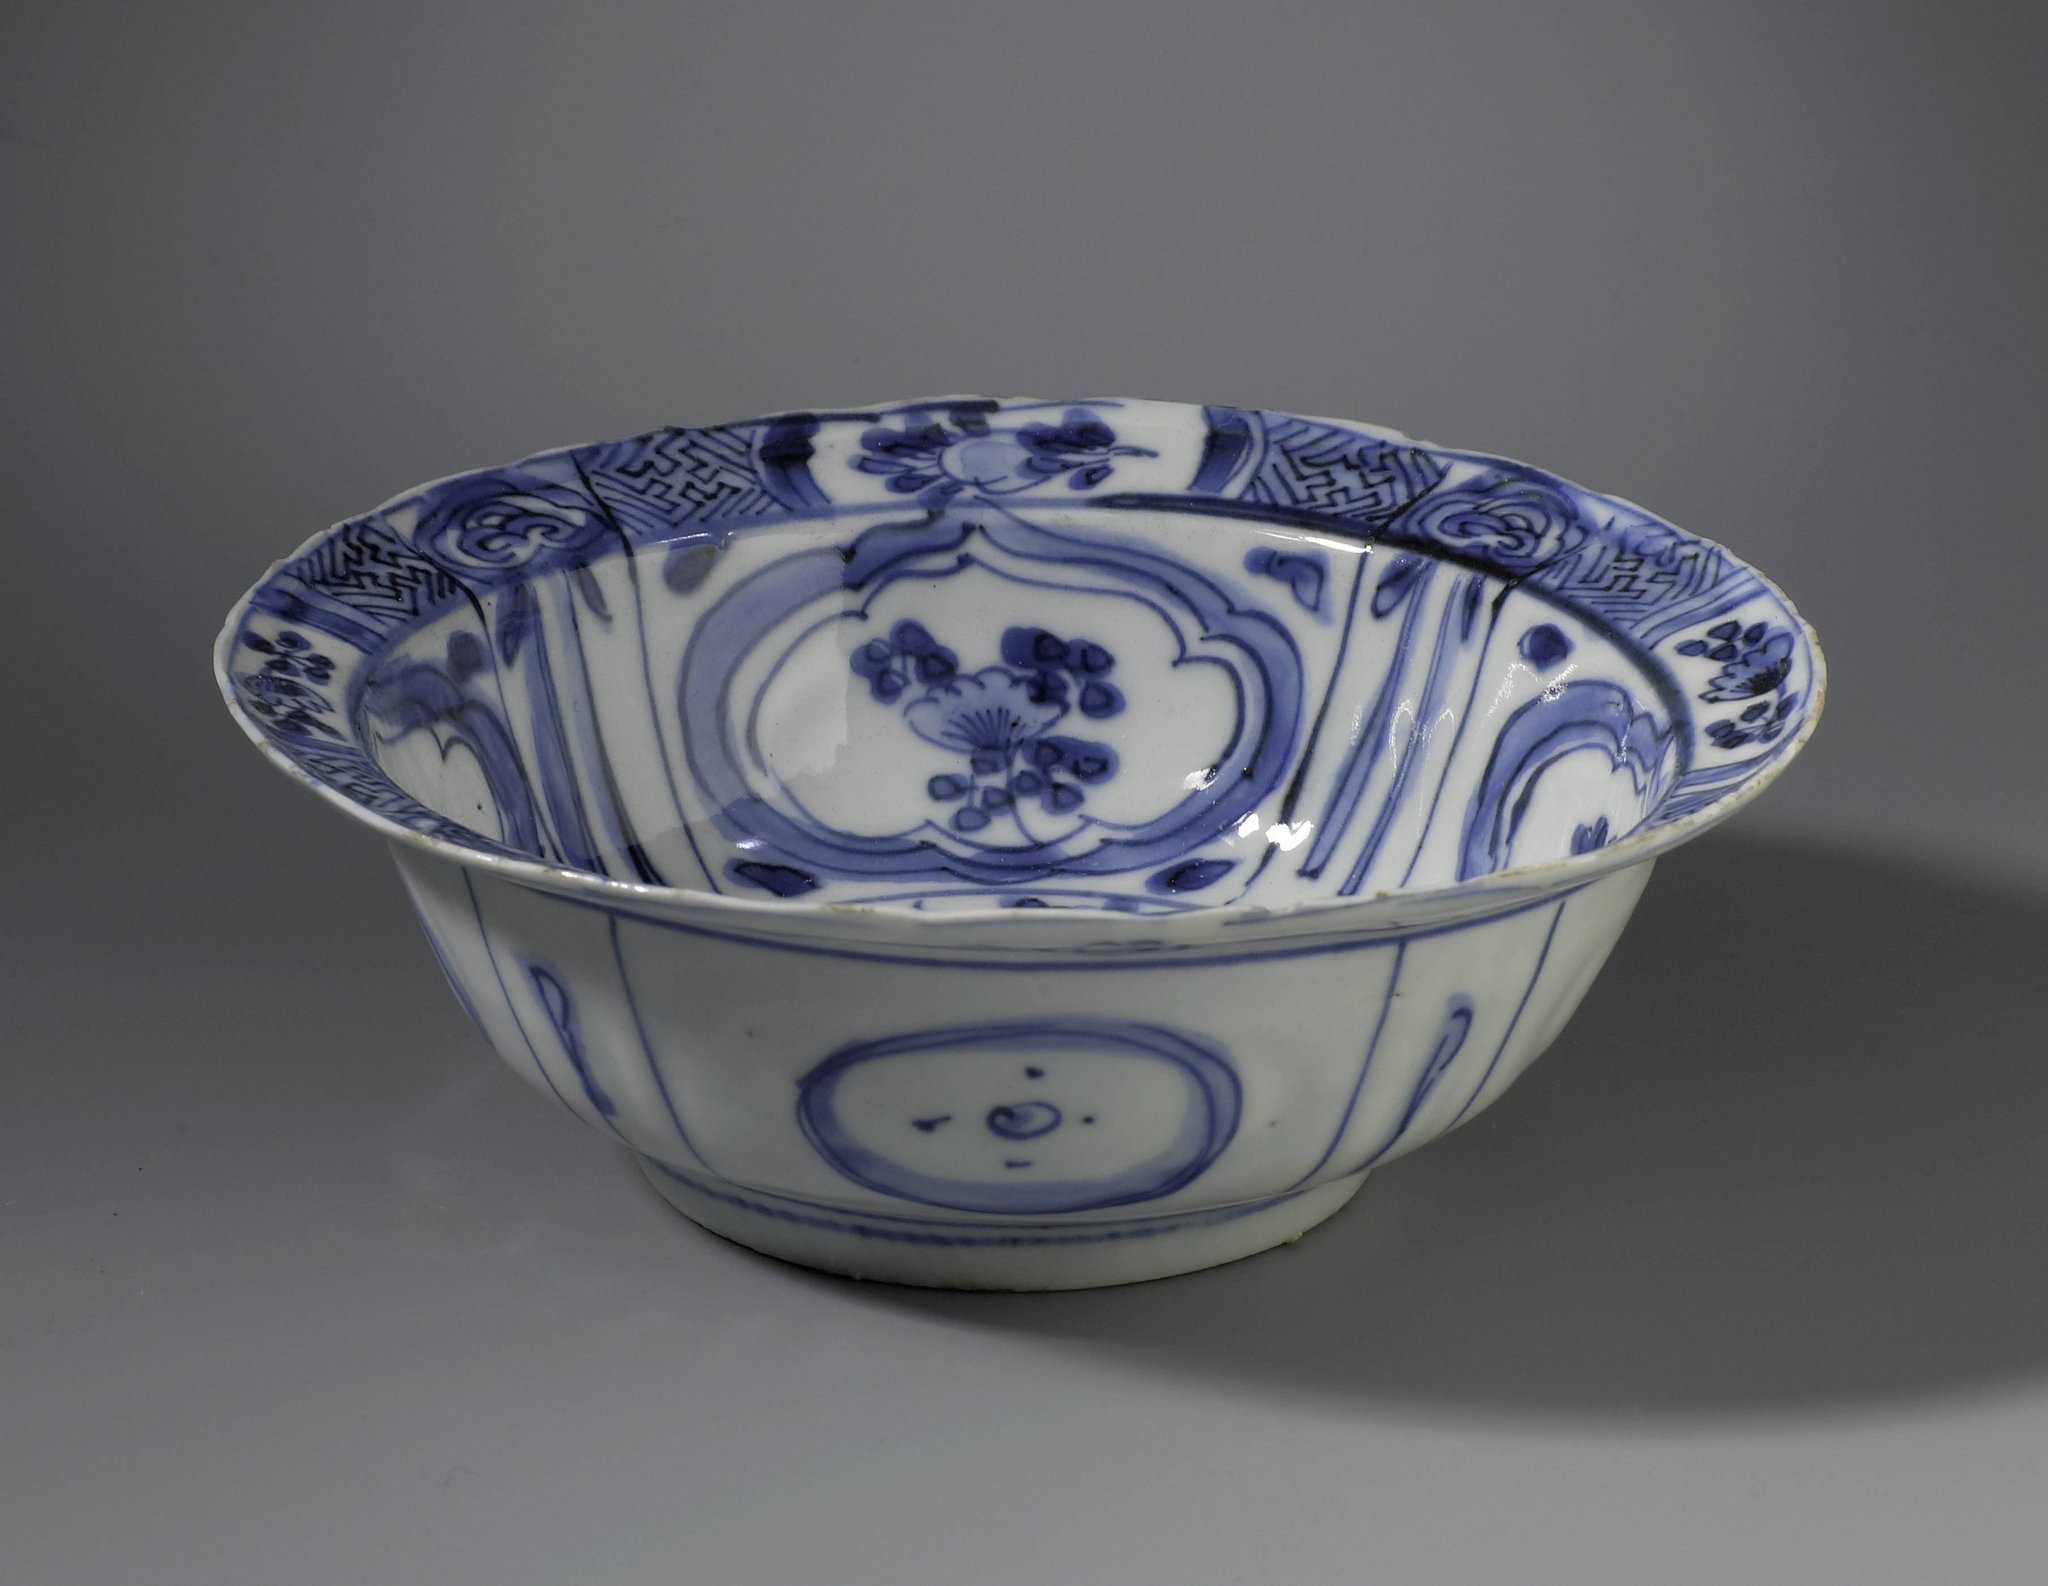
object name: bowl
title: Klapmuts bowl with a bird on a rock near flowering plants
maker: Anonymous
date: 1600-1649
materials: cobalt, glaze, paint, porcelain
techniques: firing, turning, vitrification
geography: china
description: Klapmutskom gedecoreerd in onderglazuur blauw, met in het plat bloeiende planten en bamboe bij een rots, en een decoratie in vakken met bloeiende planten en geluksymbolen op de wand en rand.